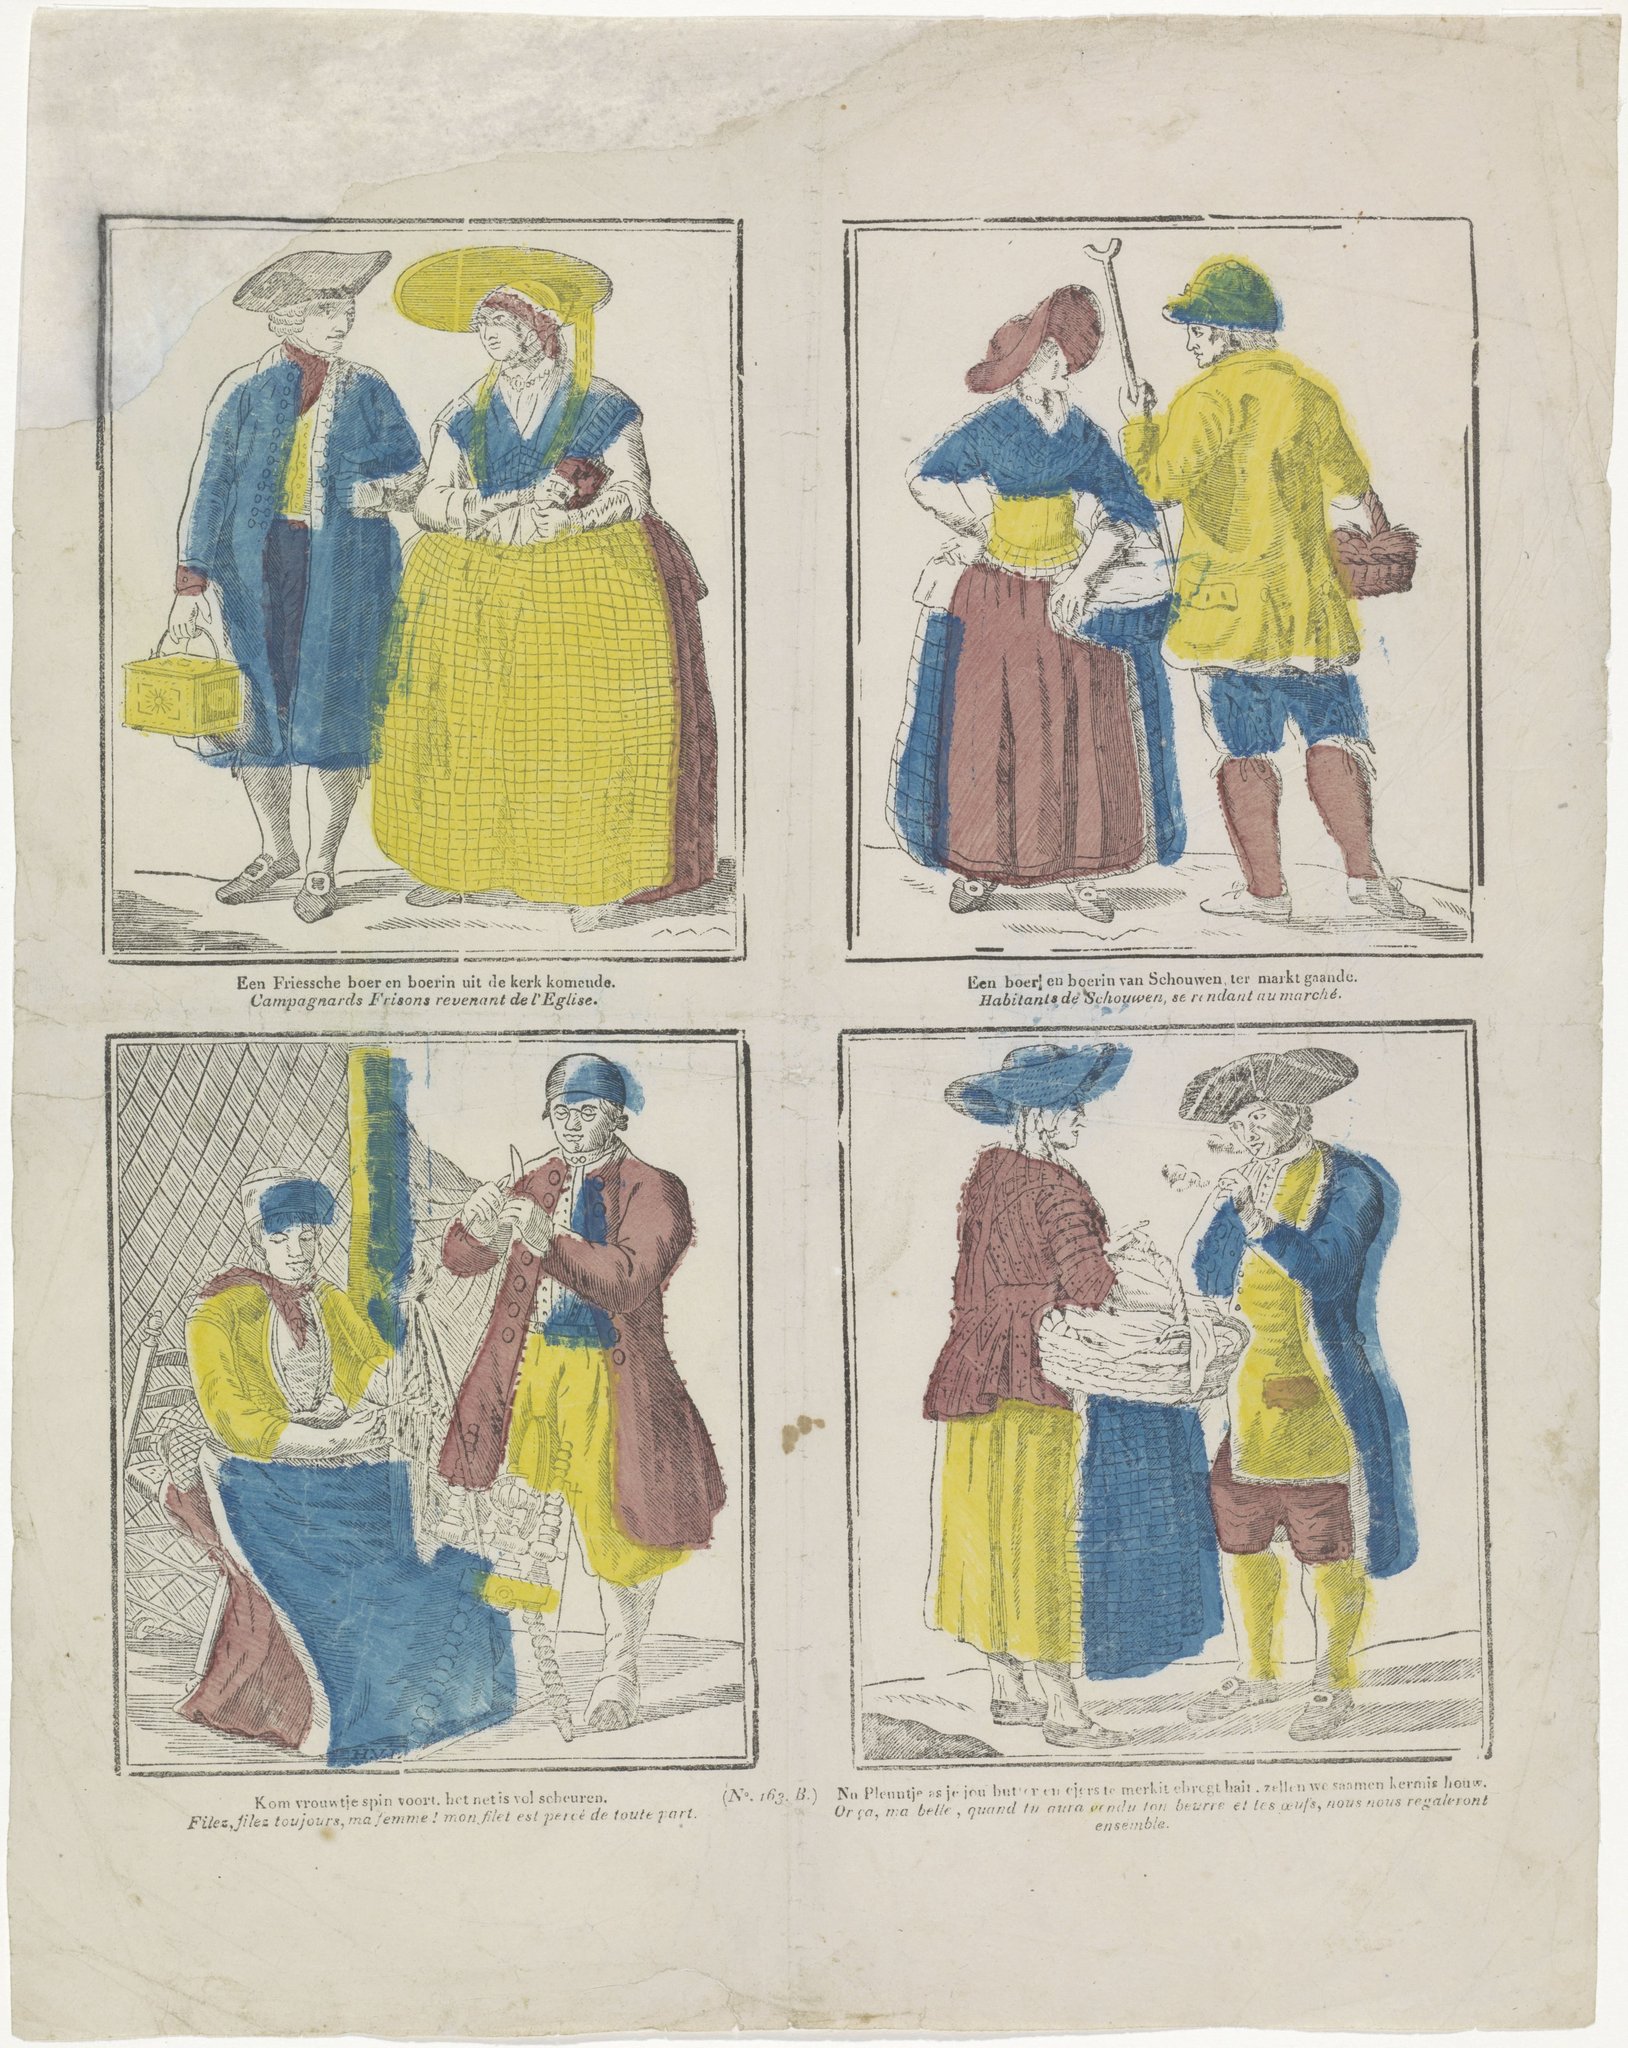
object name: print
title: Nederlandse klederdracht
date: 1800-1833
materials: paper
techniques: colour, letterpress printing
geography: turnhout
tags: historical costume, folk costume, regional costume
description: Blad met 4 voorstellingen van paren in Nederlandse klederdracht. Onder elke afbeelding een onderschrift in het Nederlands en in het Frans. Genummerd middenonder: (No. 163. B.).